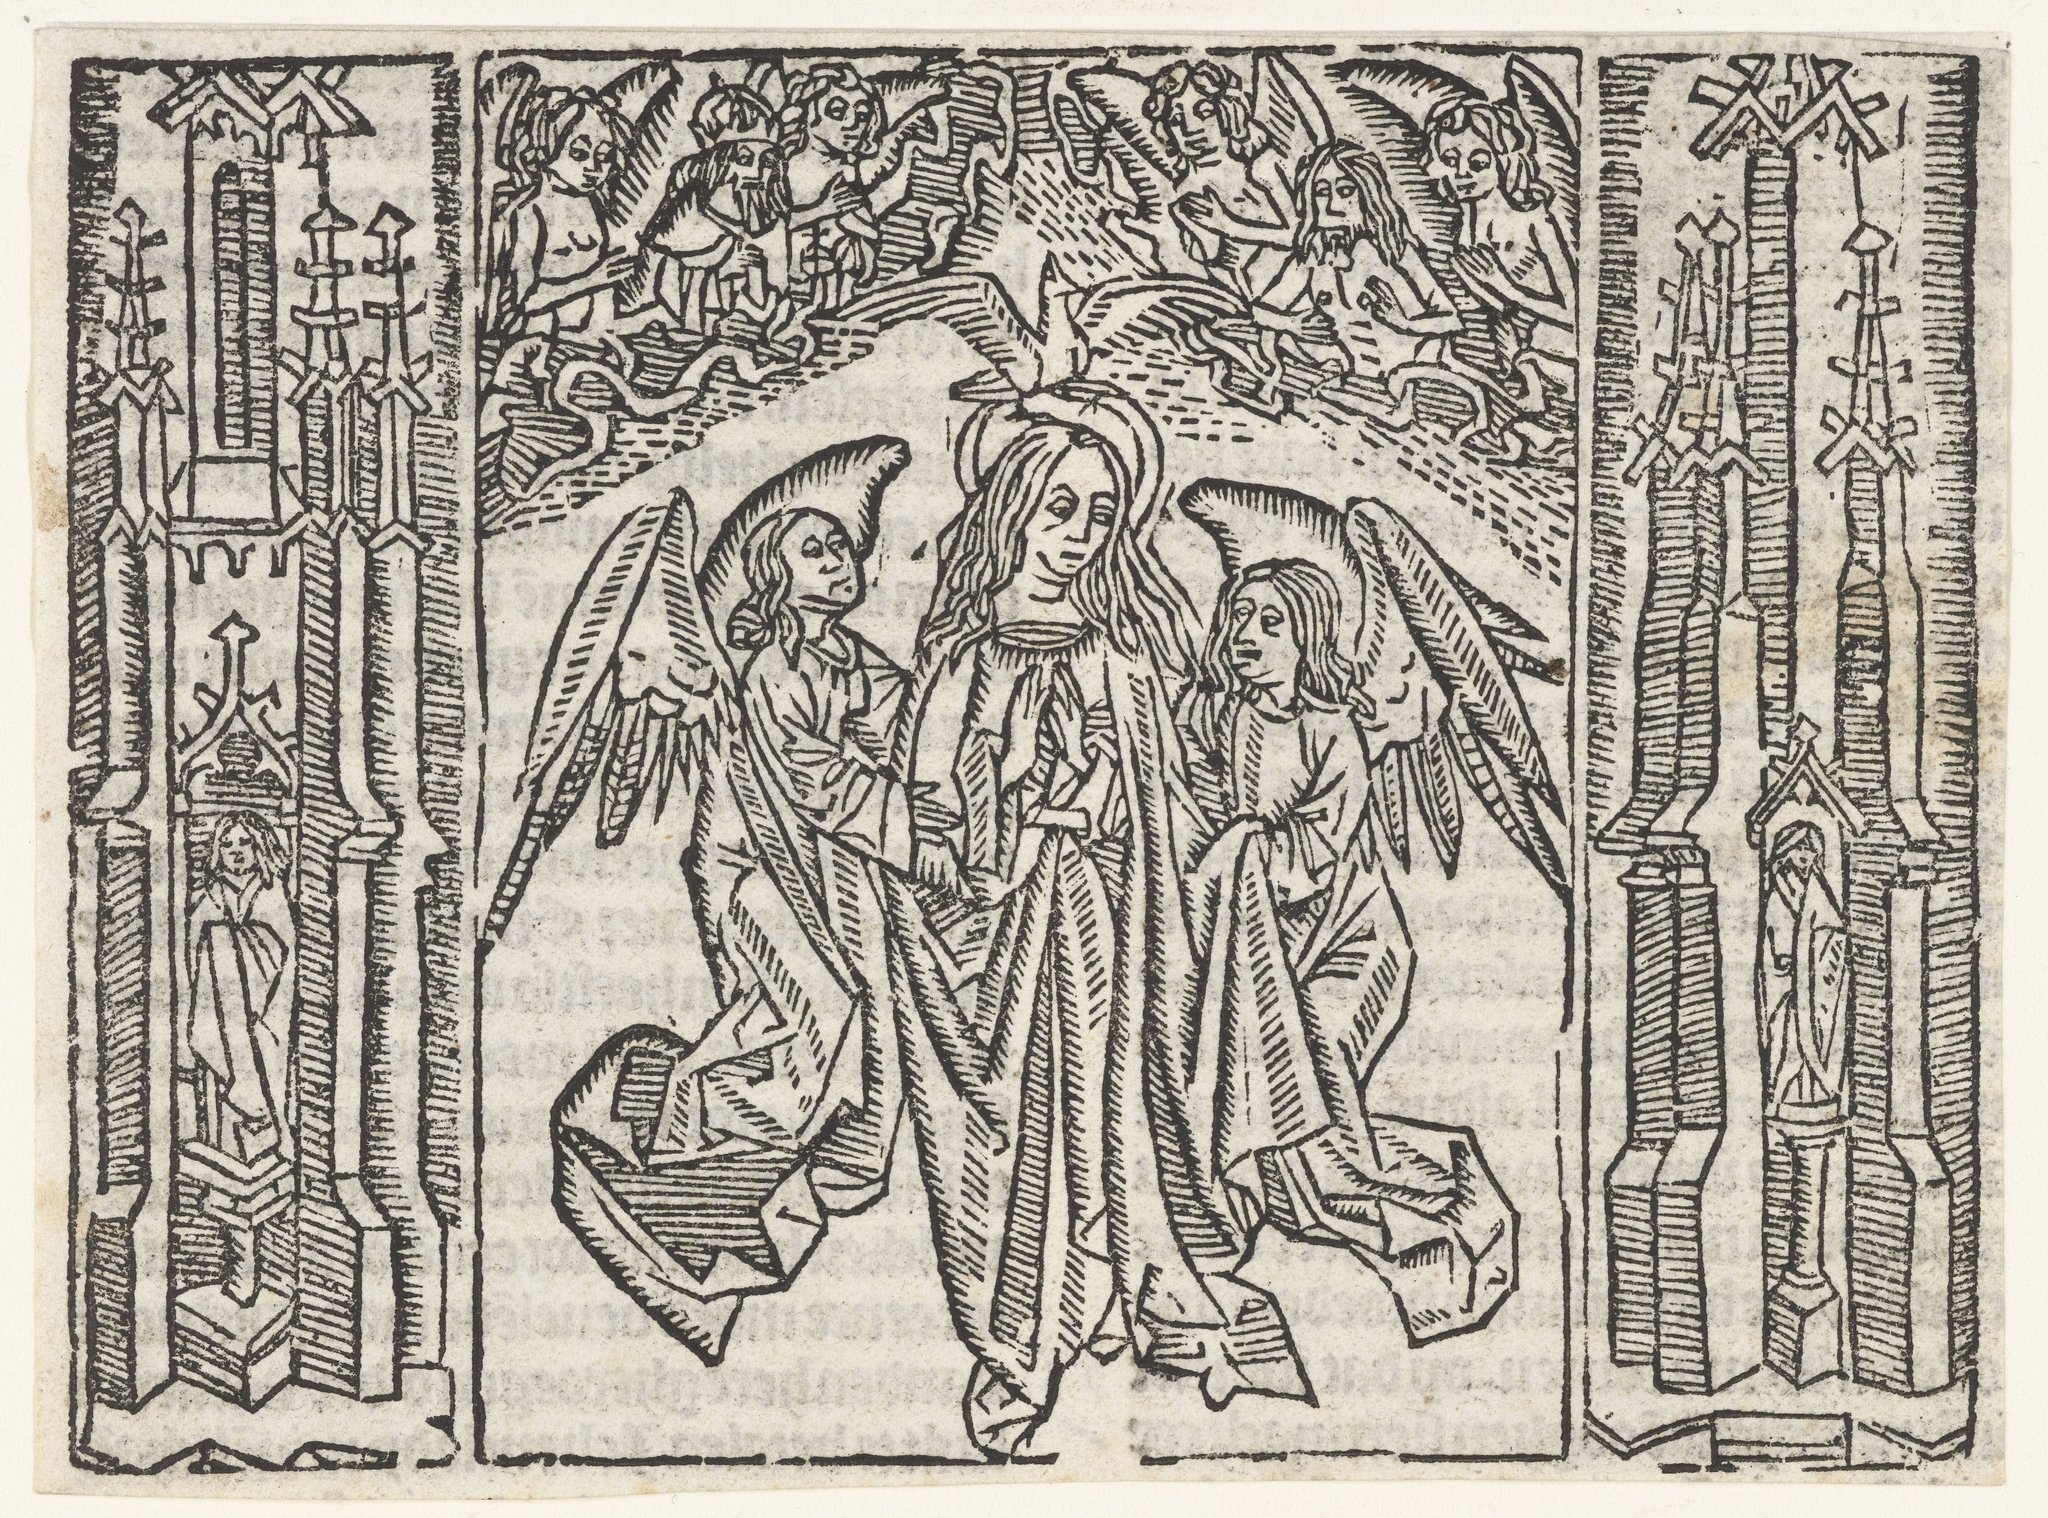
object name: print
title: De hemelvaart van Maria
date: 1480-1500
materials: paper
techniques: woodcut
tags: the assumption of mary ('assumptio corporis'): she is borne into heaven by angels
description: Eén blad van 113 uit Ludolphus de Saxonia, "Dit es dleué ons liefs heeren ihesu christi". Anonieme Nederlandse vertaling. Uitgegeven door Henrick Eckert van Homberch te Antwerpen in 1503. Botke, K. Deze 113 houtsneden, die meestal reeds in vroege Nederlandse boeken gebruikt zijn, worden toegeschreven aan de tweede Meester van Delft, de Meester van de Delbecq-Schreiber-passie en de Meester van de Virgo inter Virgines. In Conway (1884) en in "De gulden passer"(1951) zijn ook eerdere versies opgenomen. Botke, K.